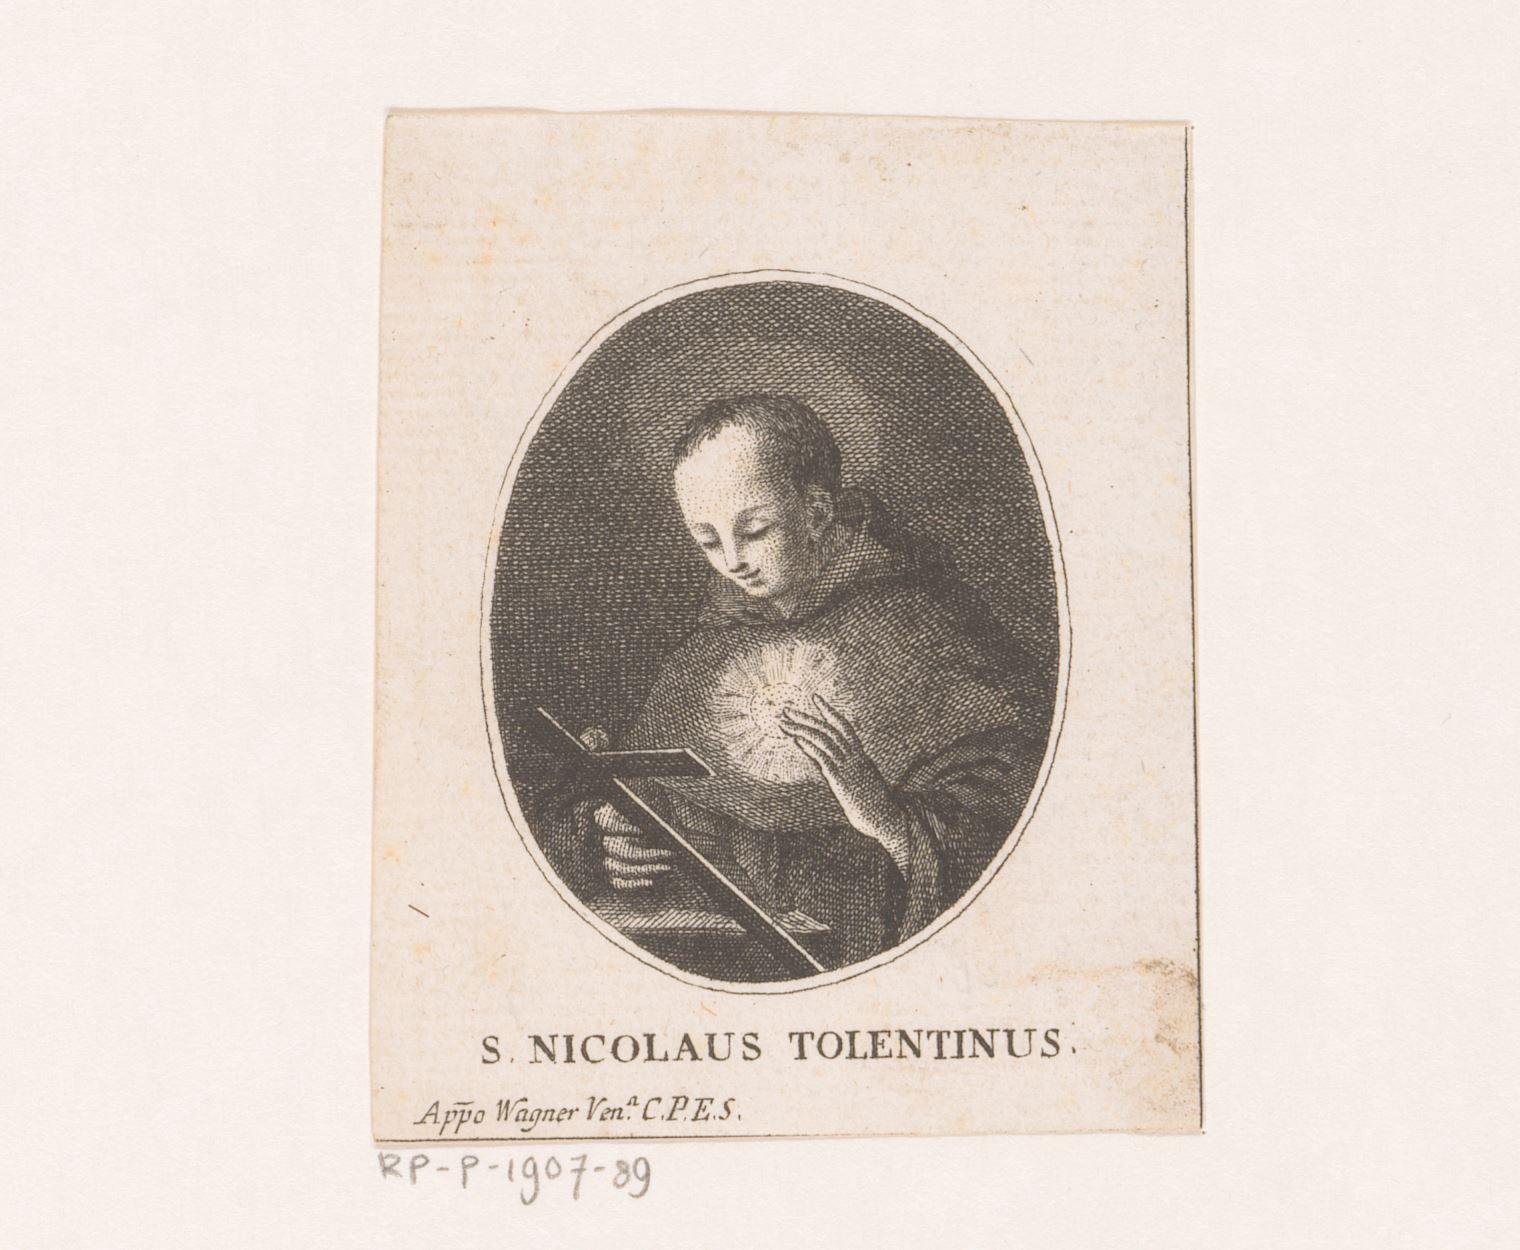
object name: print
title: Heilige Nicolaas van Tolentijn met crucifix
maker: joseph wagner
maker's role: painter, print maker, publisher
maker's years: 1706-1780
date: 1739-1780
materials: paper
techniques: engraving, etching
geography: venice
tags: crucifix ~ personal devotion, the augustine hermit, nicholas of tolentino; possible attributes: book, crucifix, (entwined with lilies), lily, (basket with) loaves, two doves (on a dish or flying away), star (on his breast), meditation over skull and/or crucifix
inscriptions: collector's mark: Lugt 2228